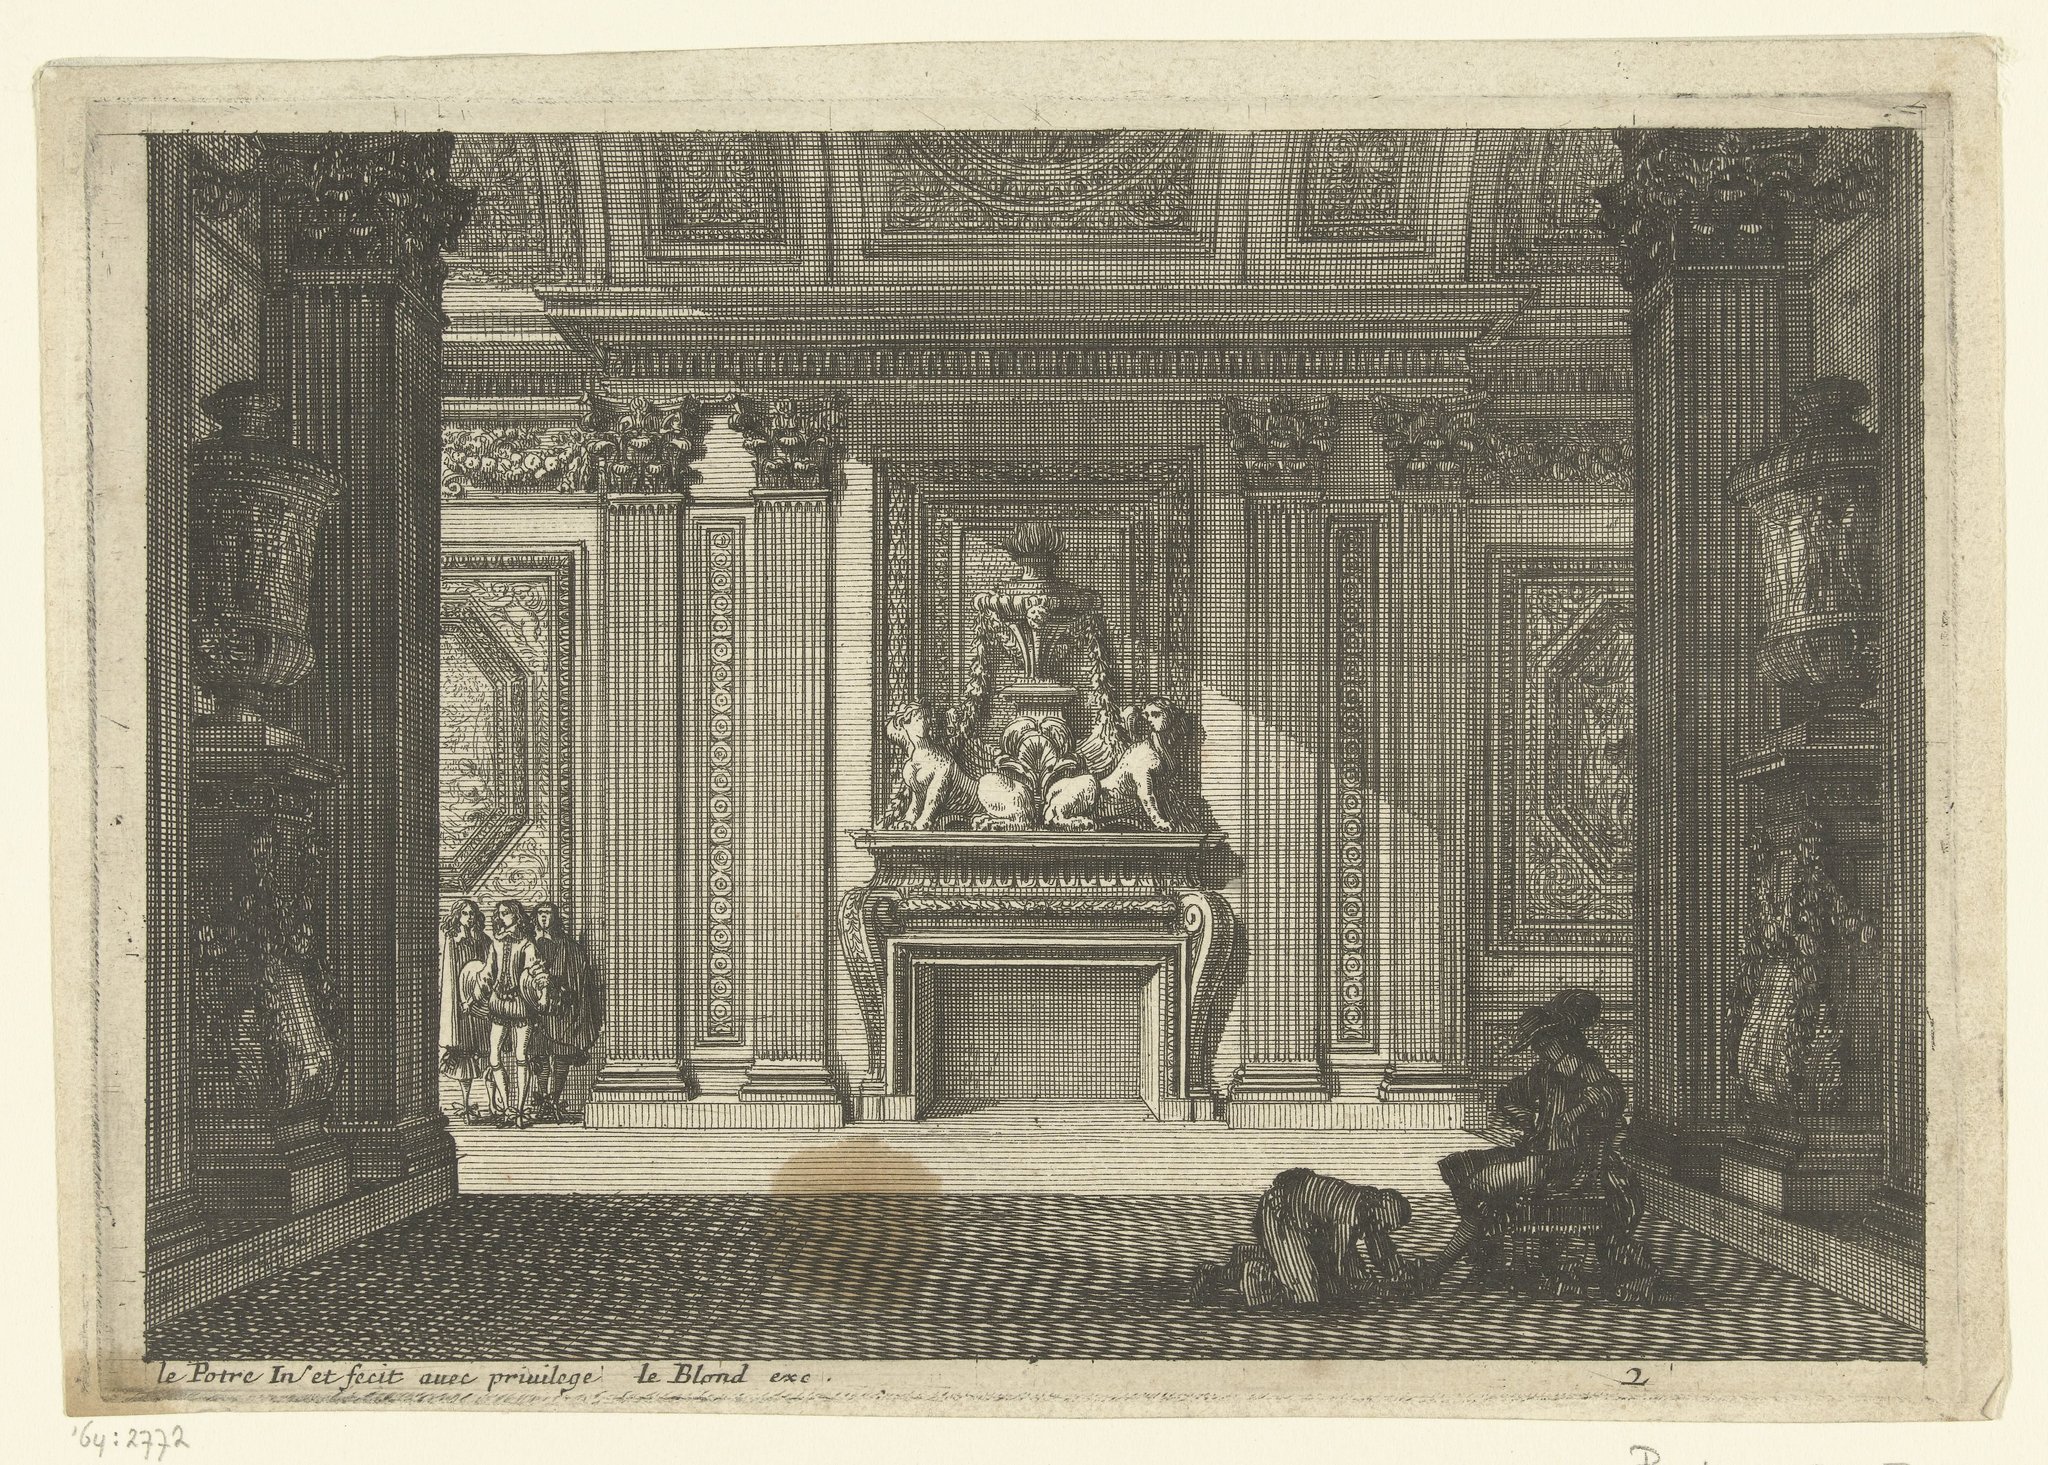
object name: ornament print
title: Schouwen en houten lambriseringen in interieurs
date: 1650-1664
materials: paper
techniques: etching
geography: paris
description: Schouw tussen dubbele Korinthische pilasters in een galerij. Rechts in de voorgrond zit een man, een bediende schoeit hem.